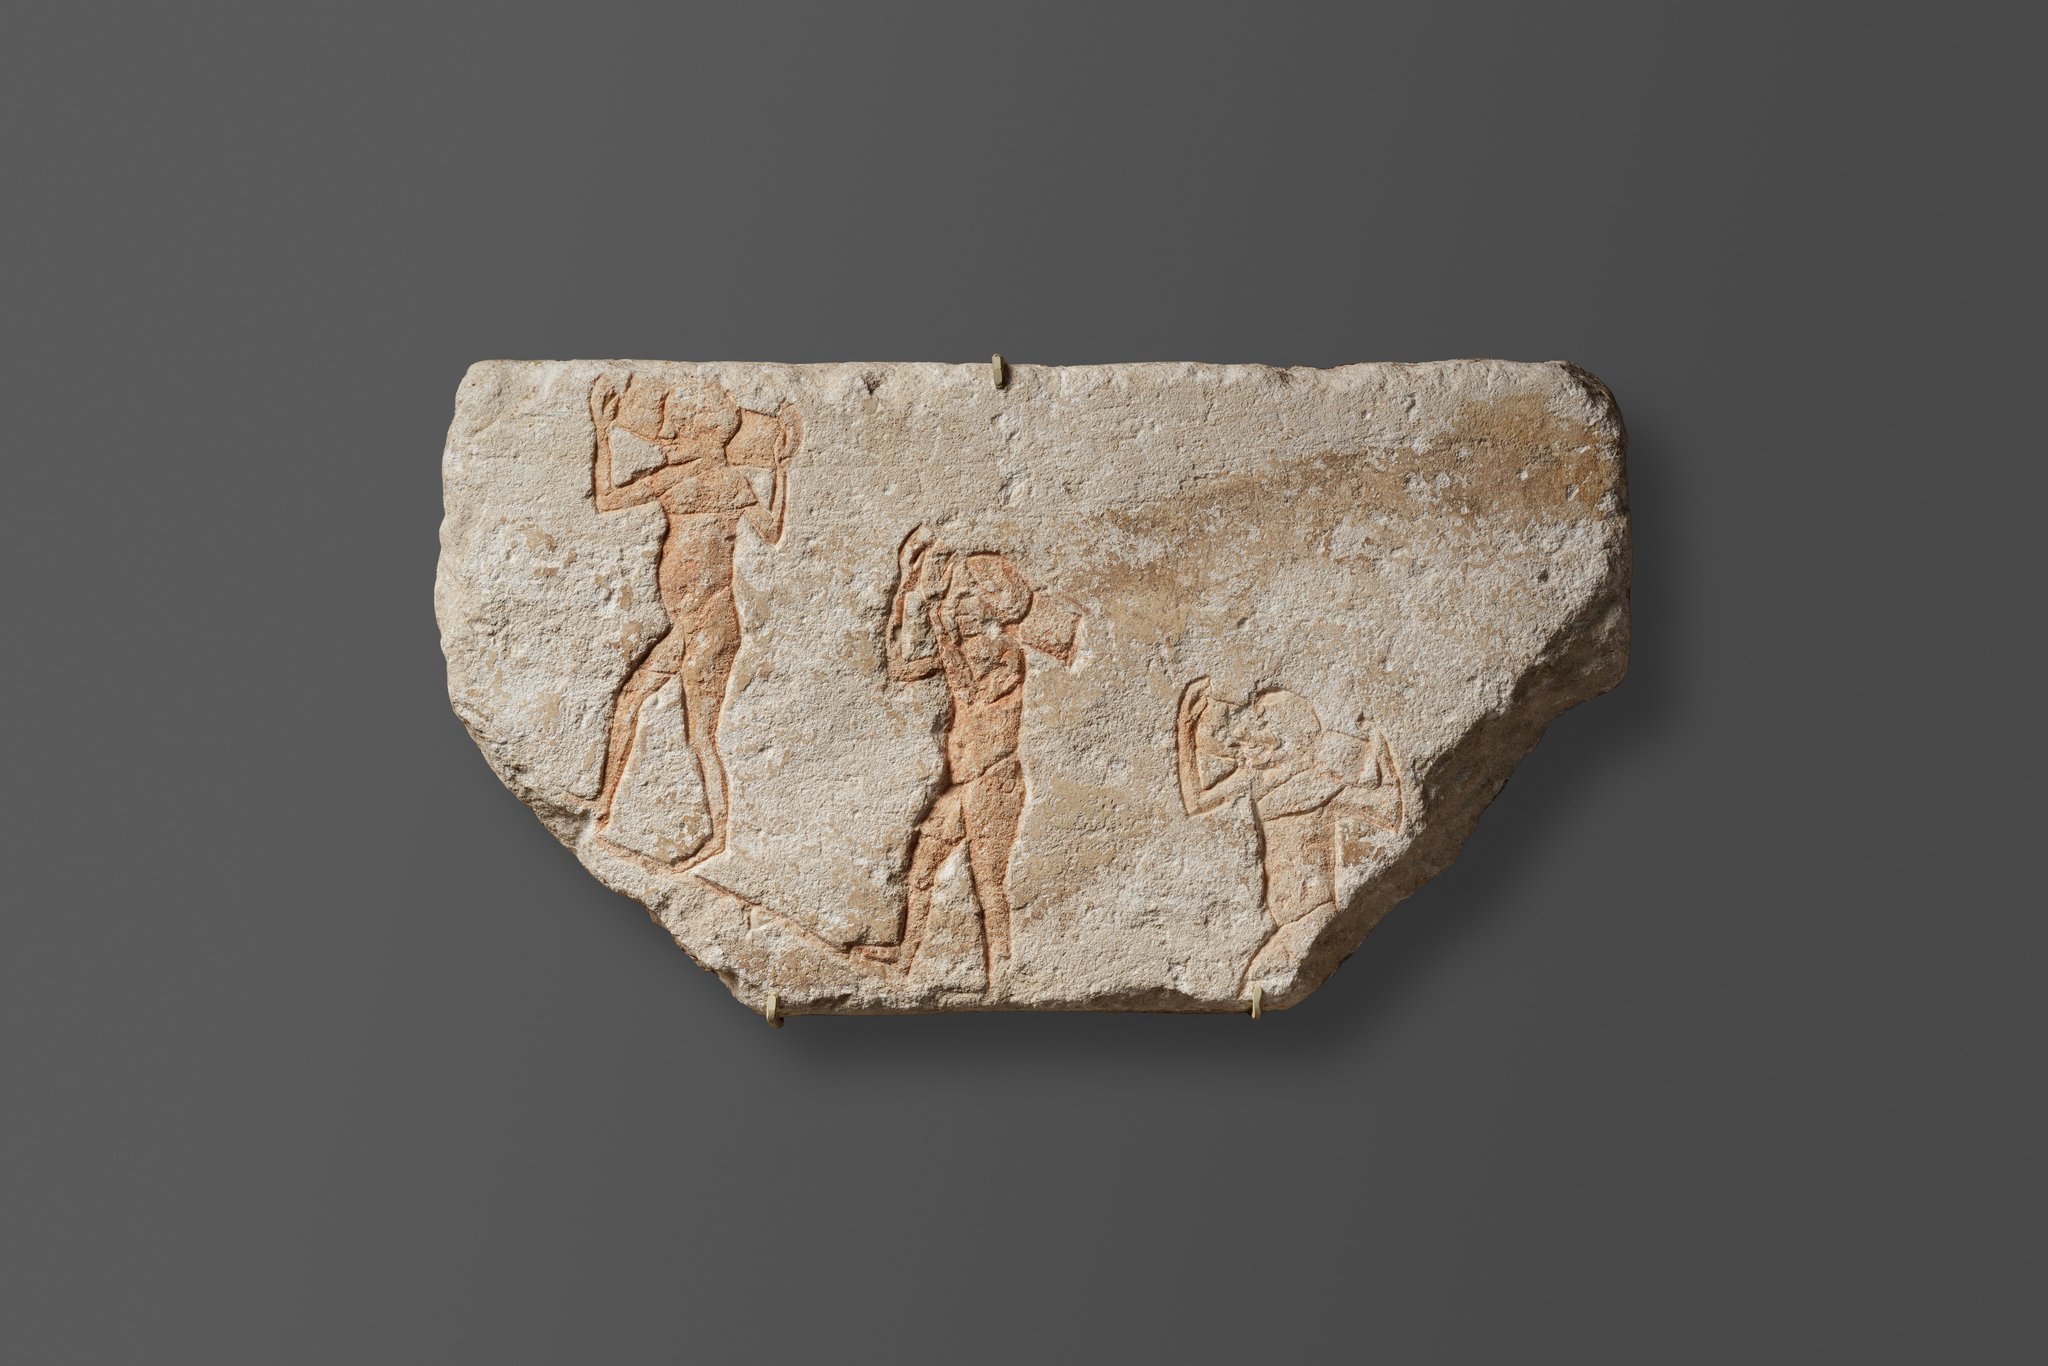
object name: talatat, three men, ramp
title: Relief with three men on a ramp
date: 1353-1336 BCE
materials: limestone, paint